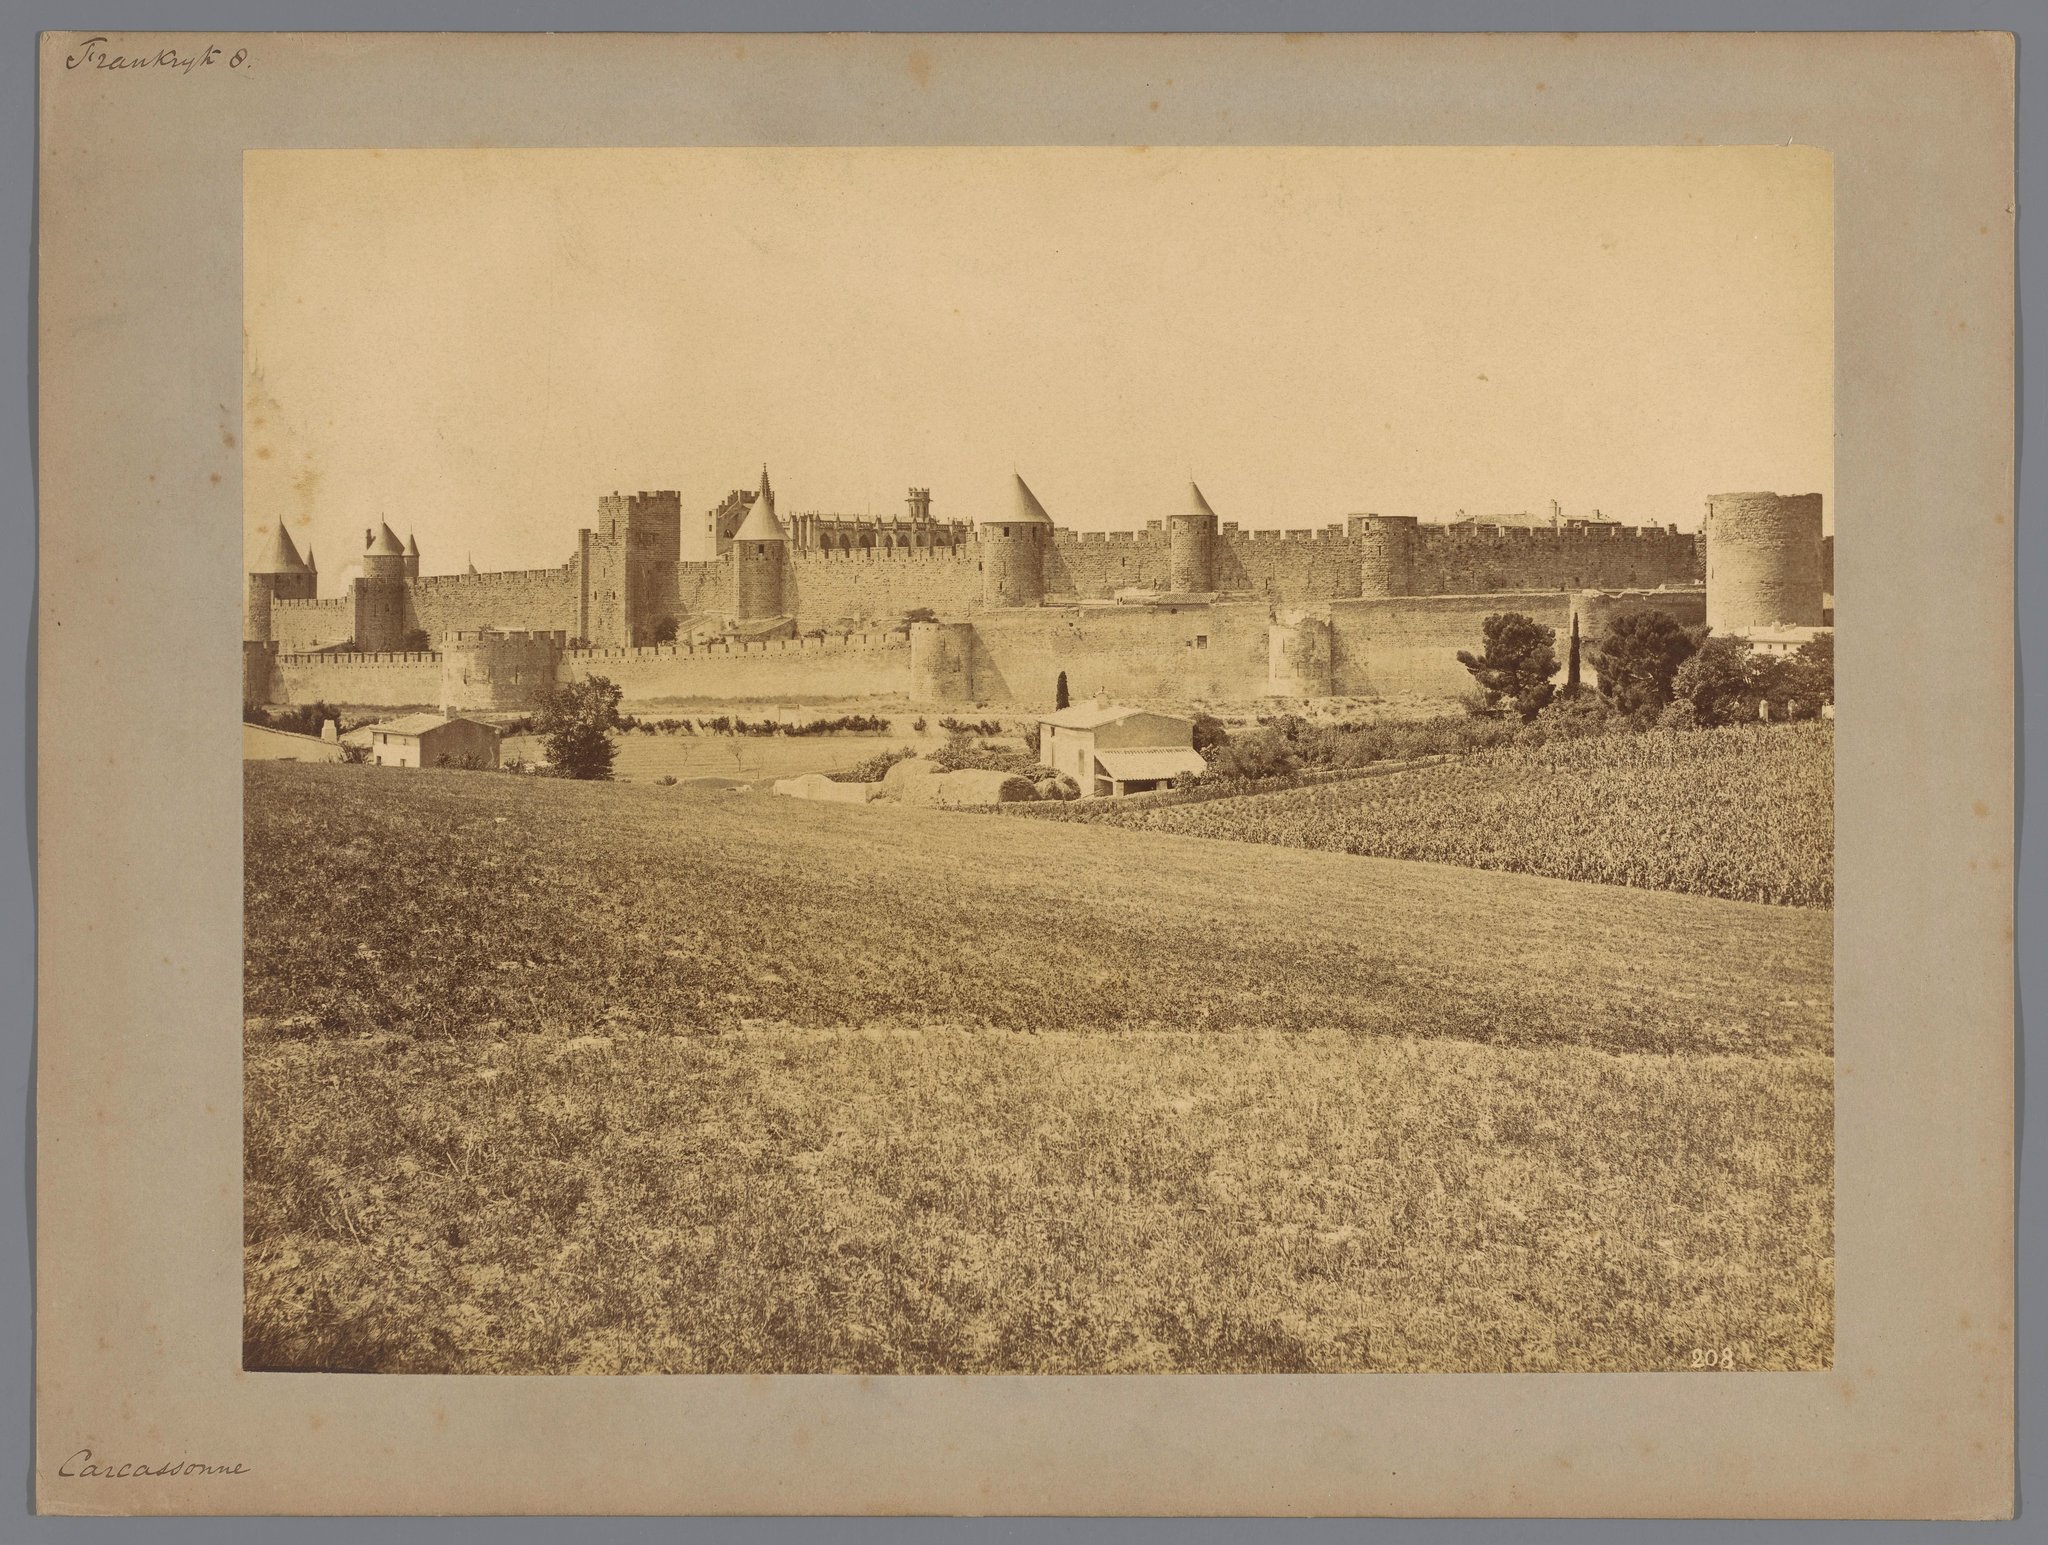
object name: photograph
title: Carcassonne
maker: Anonymous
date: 1850-1900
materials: cardboard, photographic support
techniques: albumen print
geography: carcassonne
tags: city-view in general; 'veduta'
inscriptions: collector's mark: ‘Rijks-normaalschool voor teekenonderwijzers Amsterdam’ Lugt 3937, number: ‘208’, number: ‘Frankrijk 8’